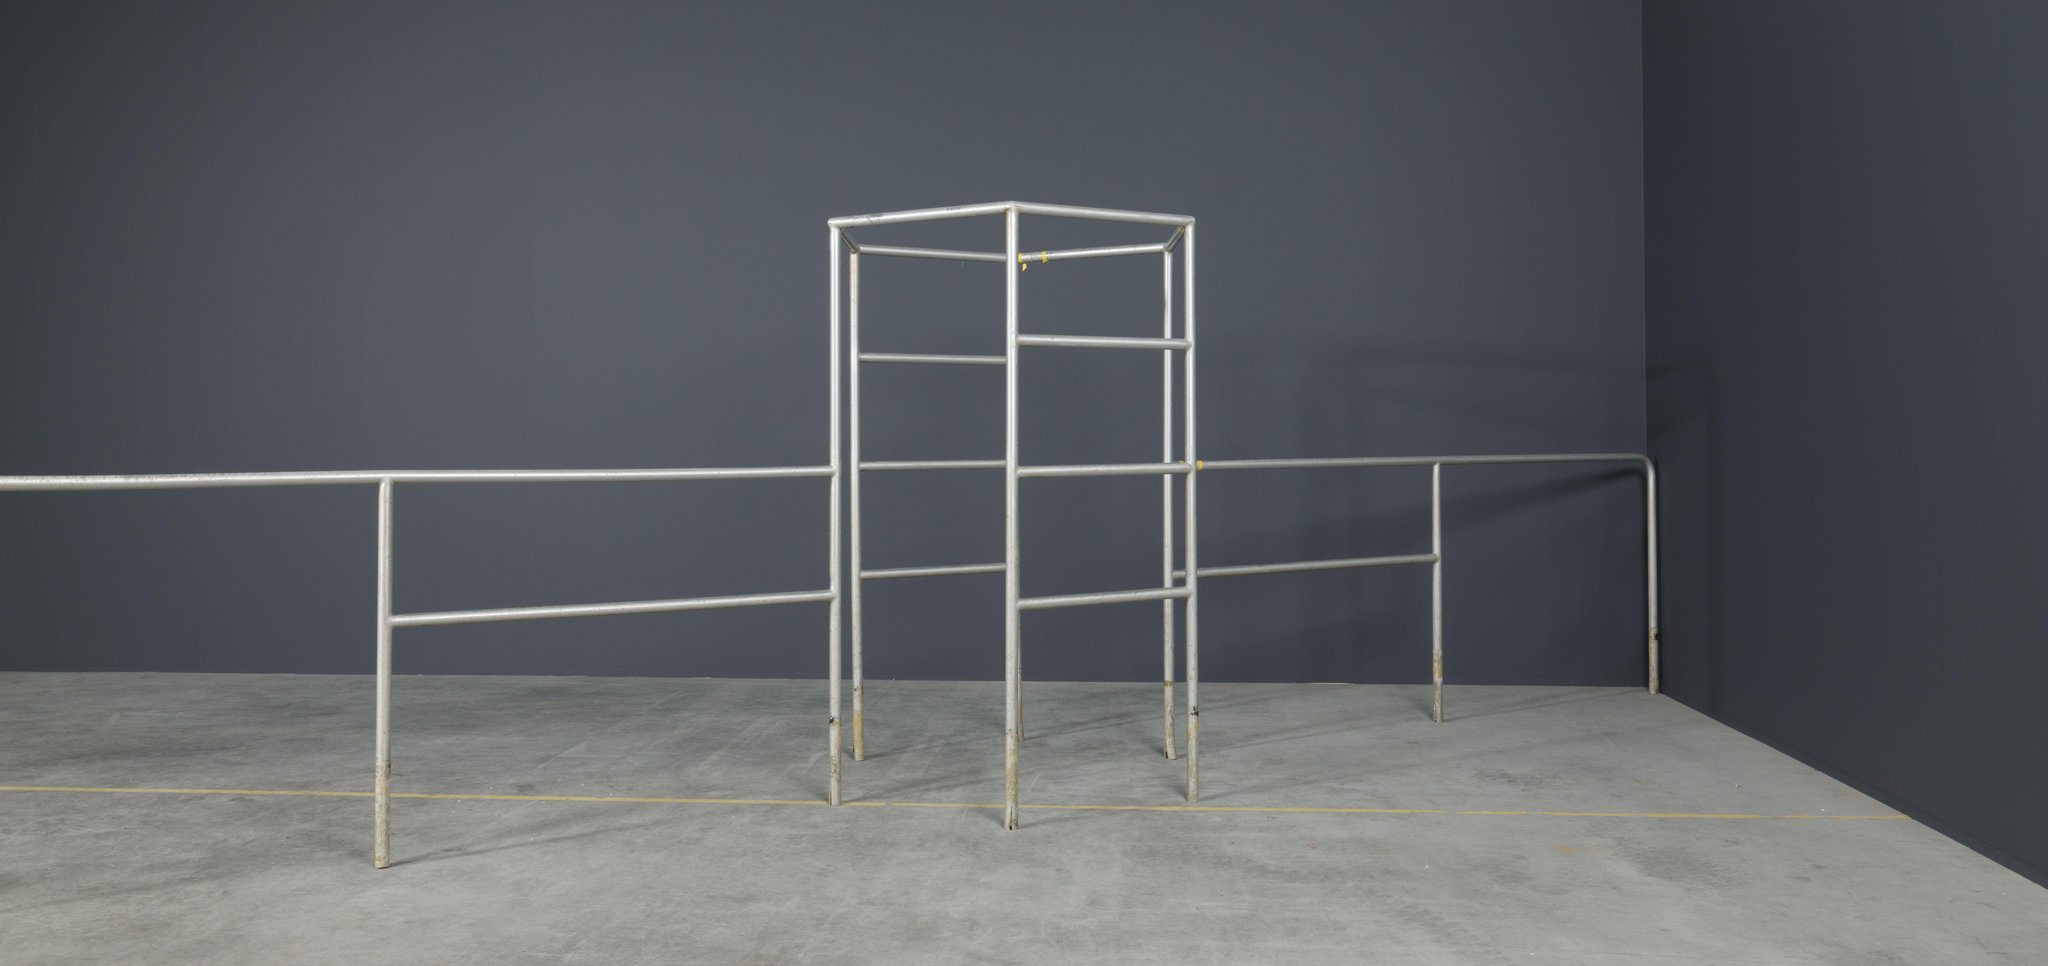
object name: speeltoestel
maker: aldo van eyck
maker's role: architect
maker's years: 1918-1999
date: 1962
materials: aluminum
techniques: welding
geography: kinderdijk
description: Aluminium buis, onderdeel van een speeltoestel.